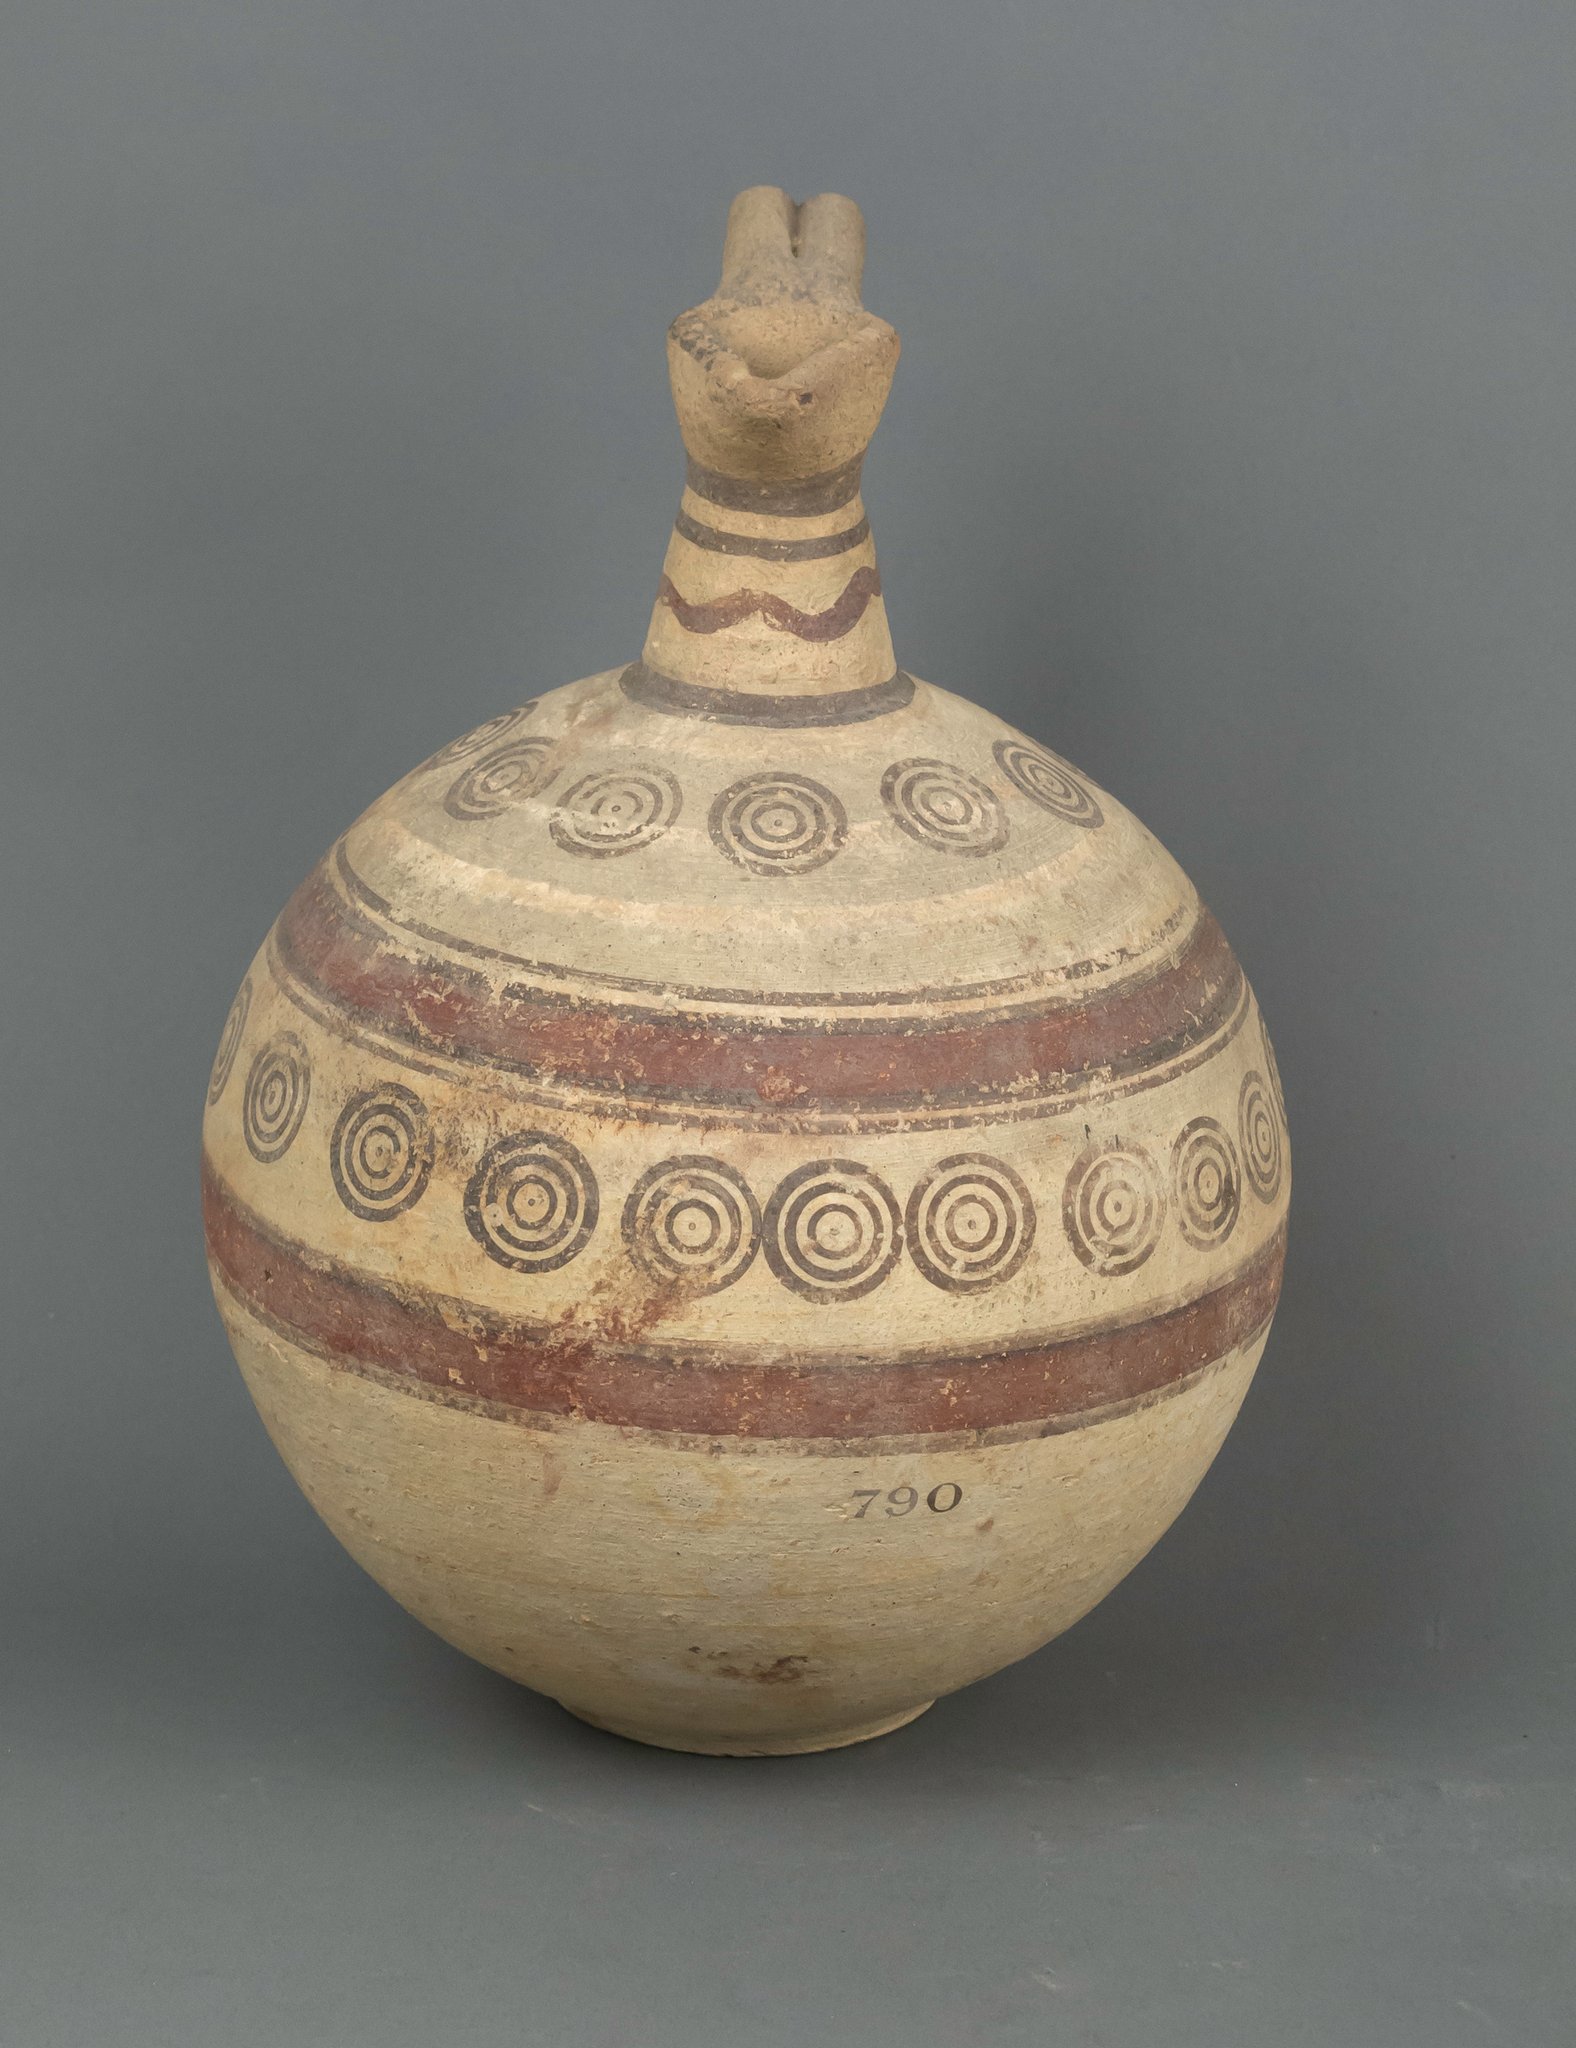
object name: oinochoe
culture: cypriot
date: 507-323 BCE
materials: terracotta